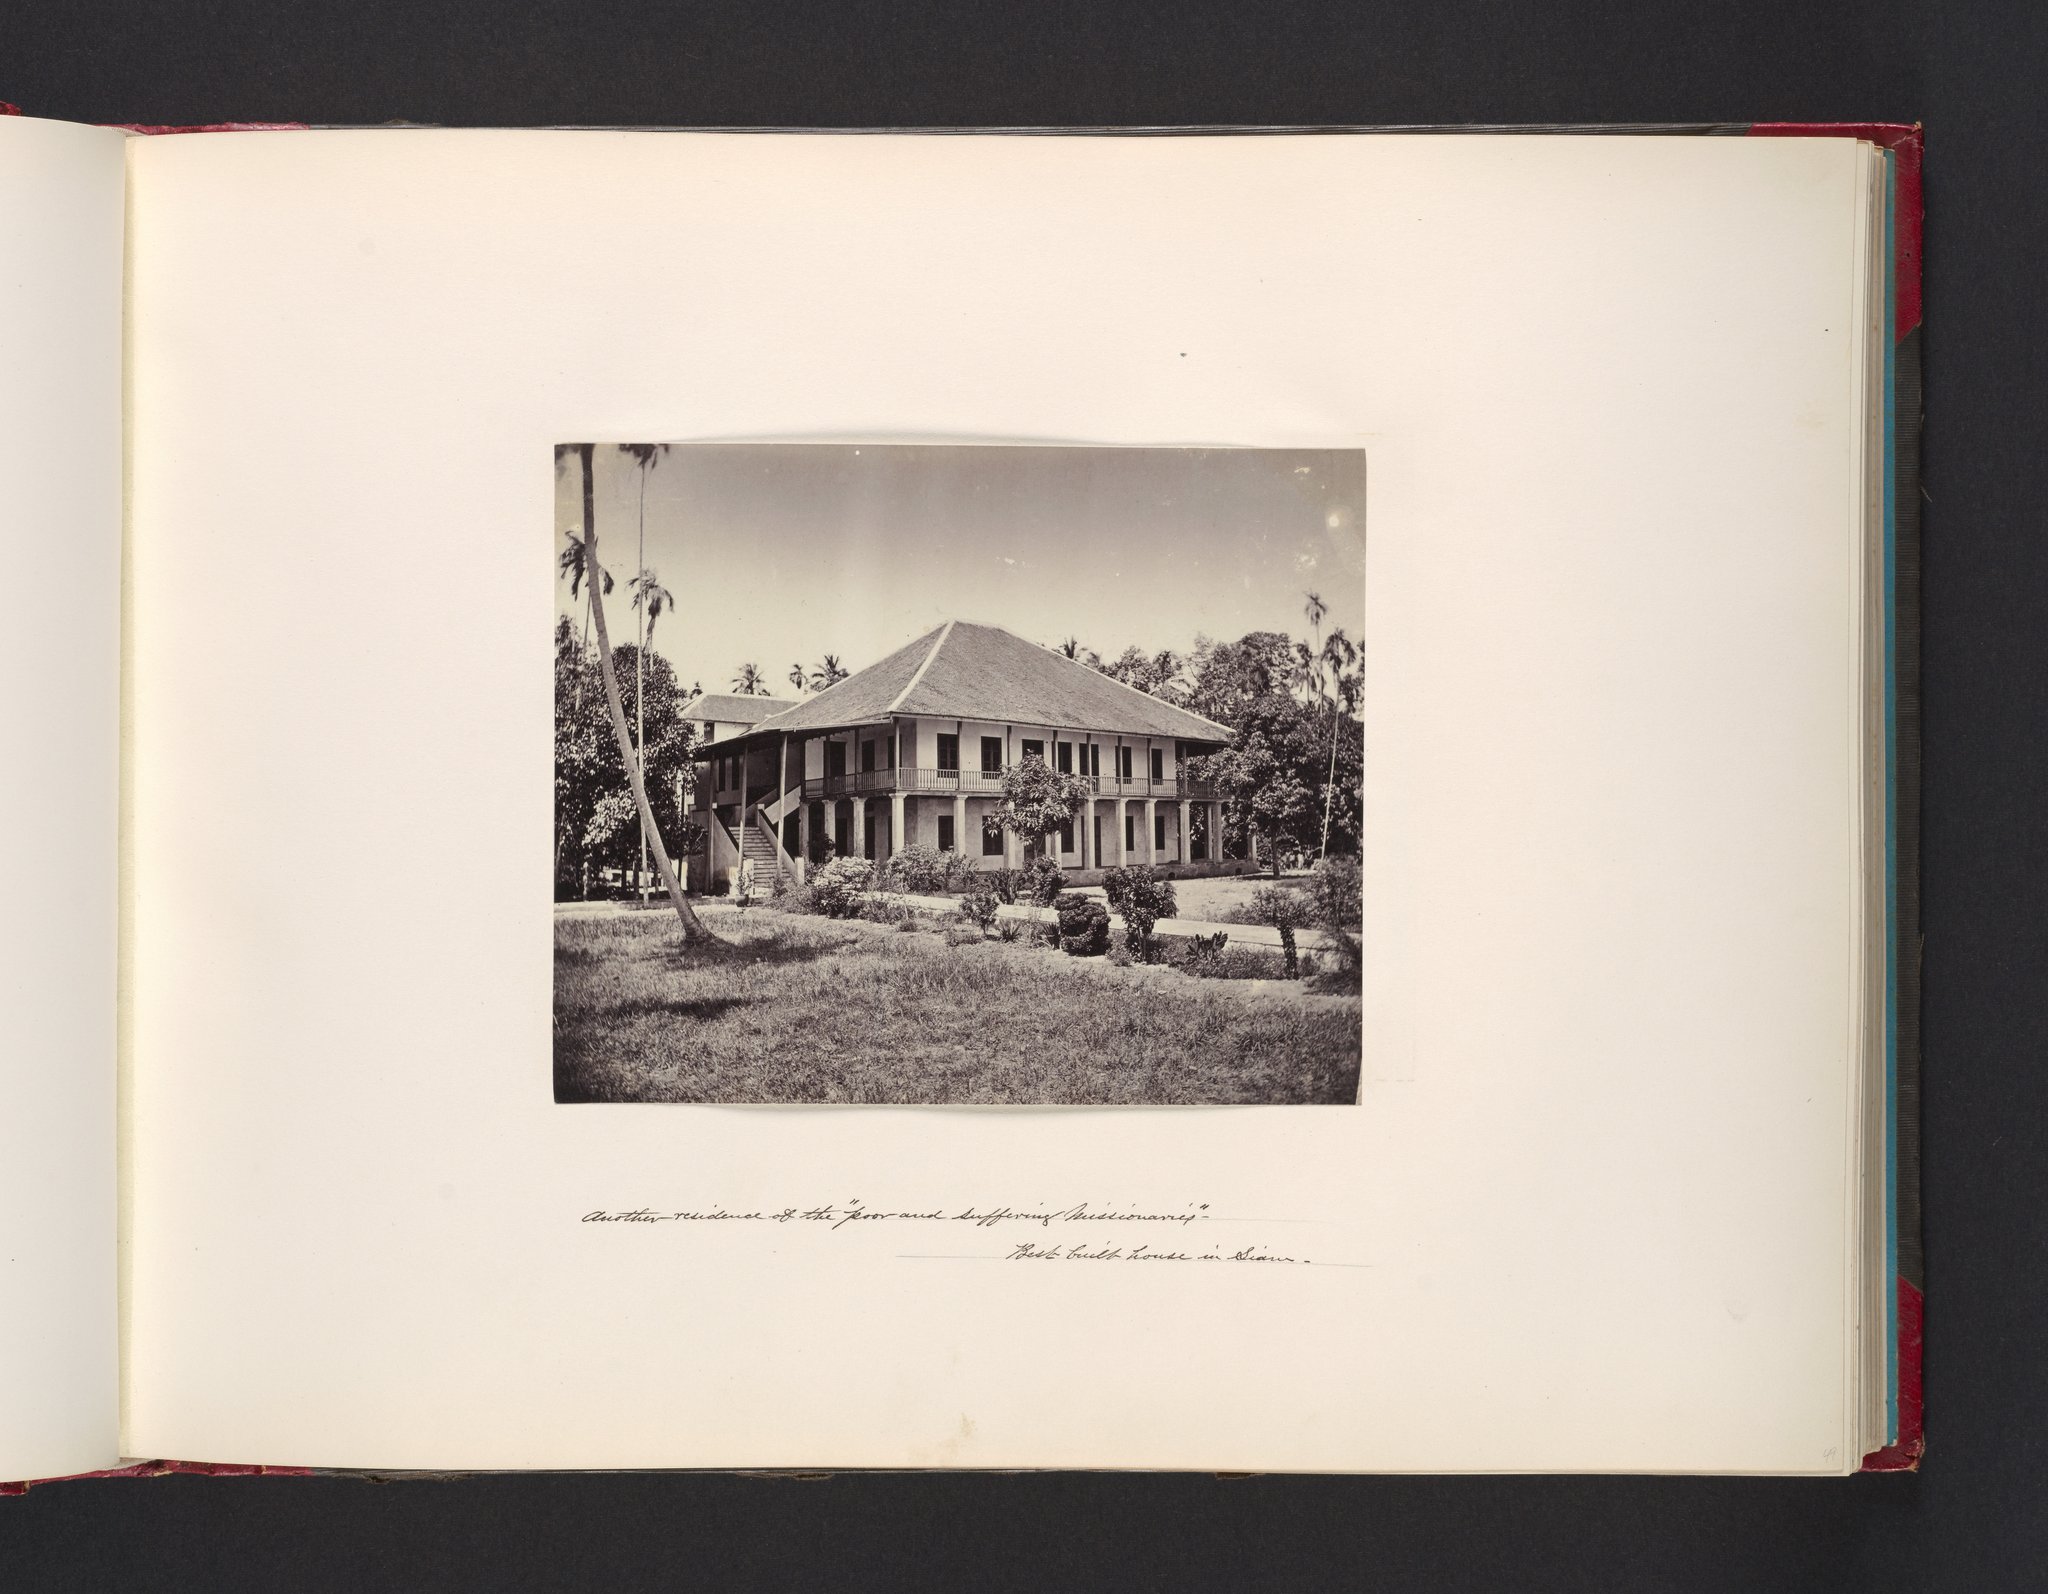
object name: photograph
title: Another Residence of the "Poor and Suffering Missionaries", Best Built House in Siam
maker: john thomson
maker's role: artist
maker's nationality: british, scottish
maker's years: 1837-1921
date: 1865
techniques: albumen silver print, glass negative